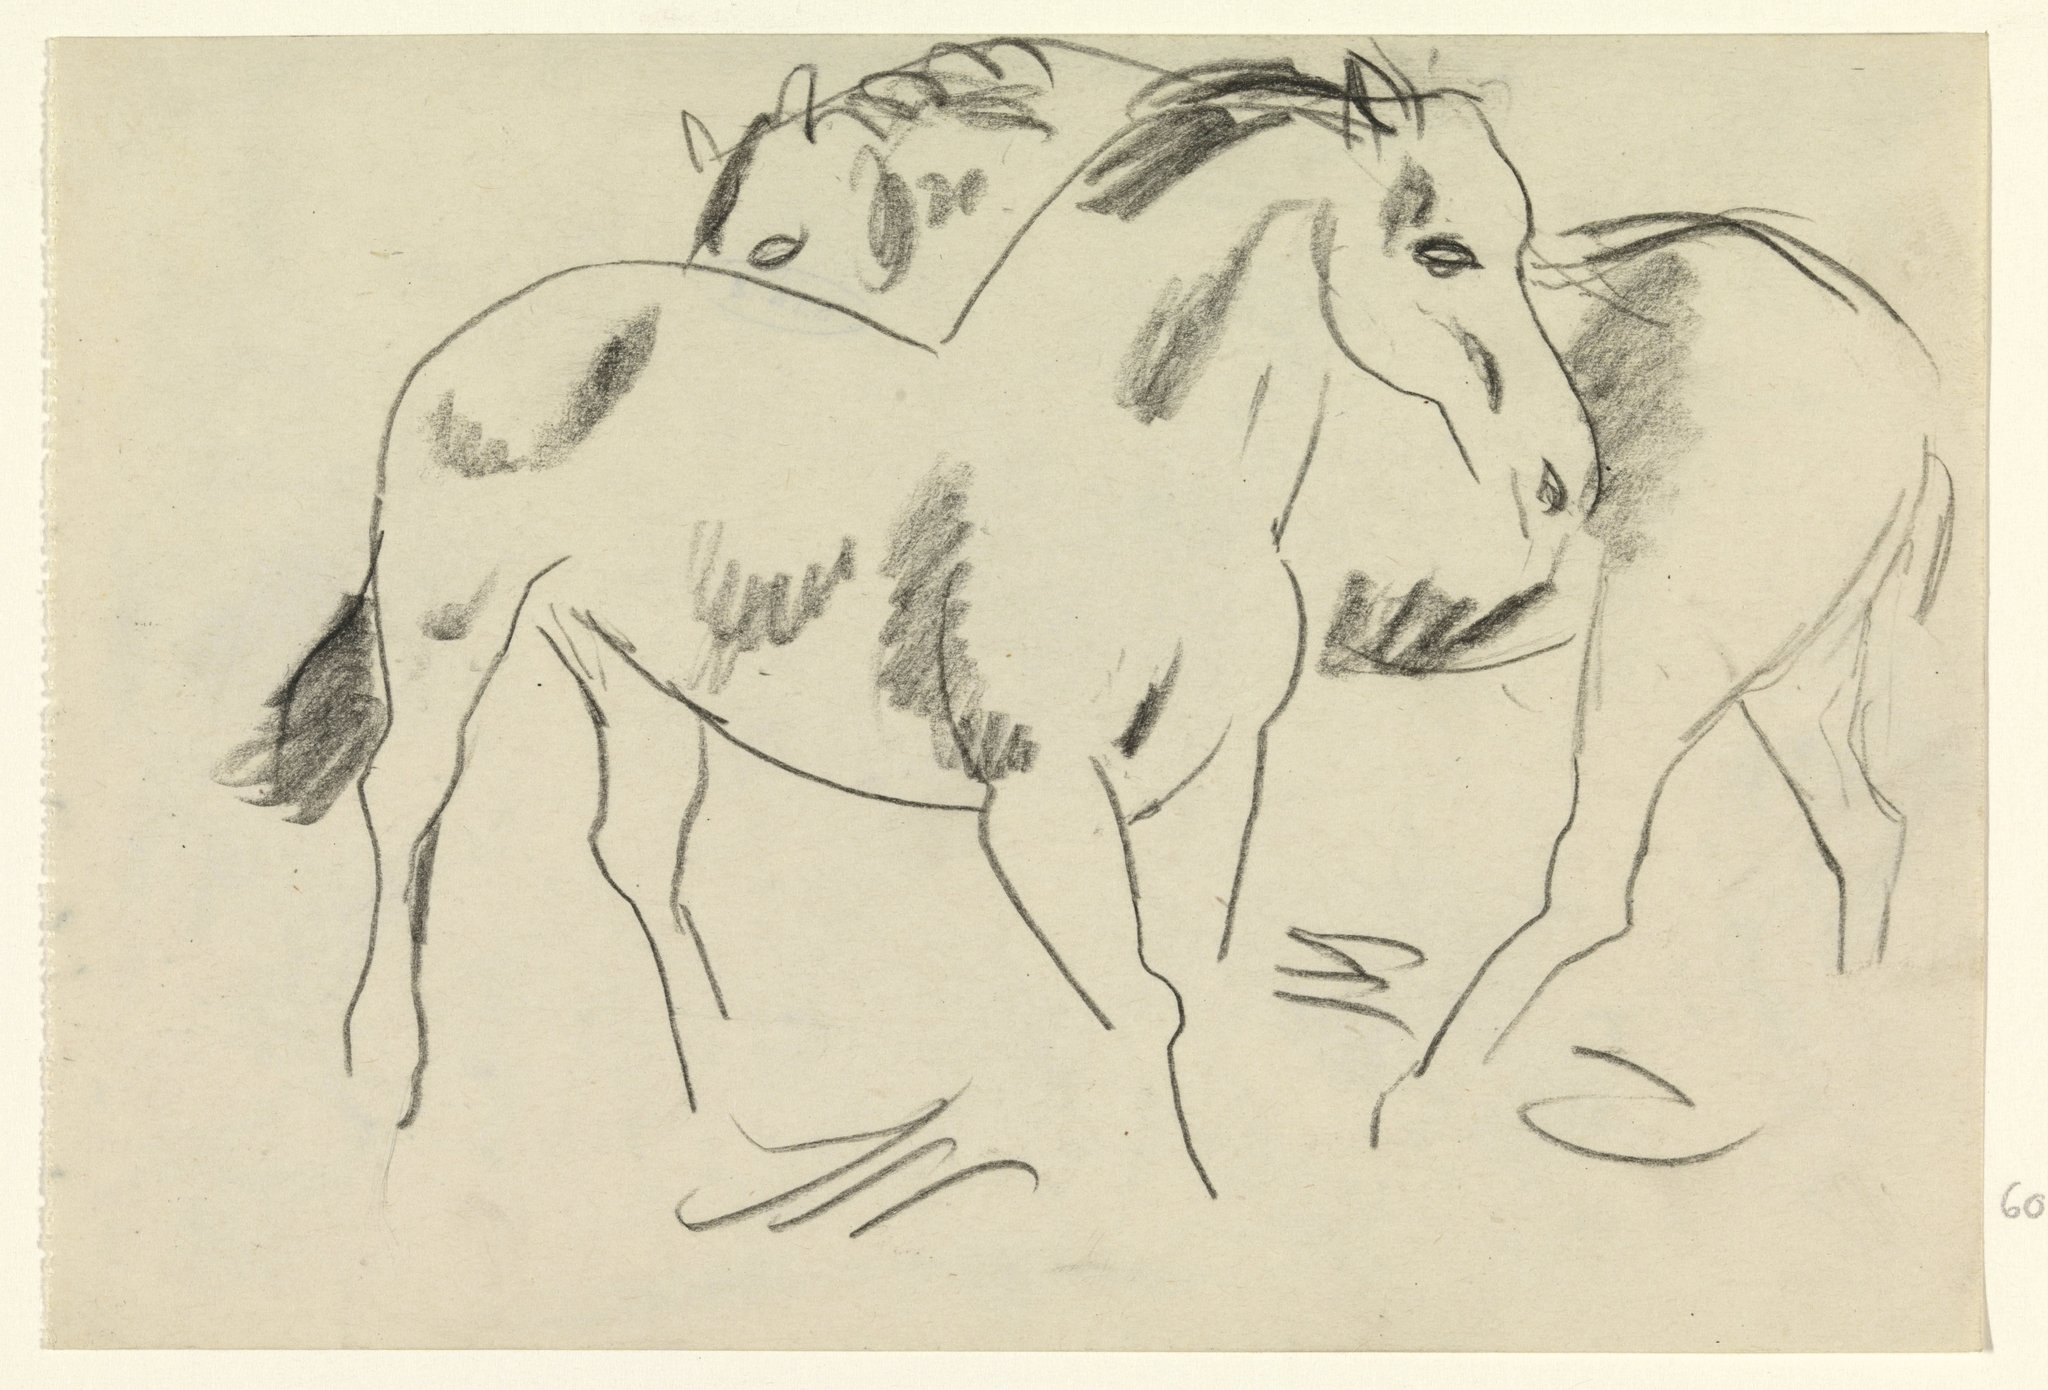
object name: drawing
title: Twee paarden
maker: leo gestel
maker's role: draughtsman, print maker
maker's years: 1881-1941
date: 1891-1941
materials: chalk, paper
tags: horse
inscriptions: collector's mark: Lugt 2228